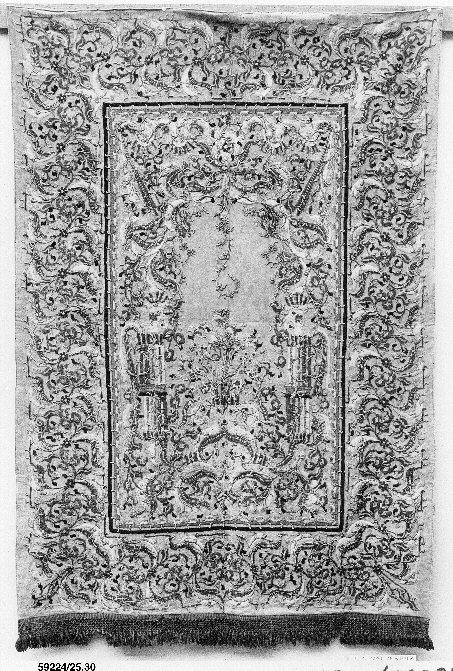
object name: hanging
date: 1767-1800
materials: metal thread, silk, wool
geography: turkey